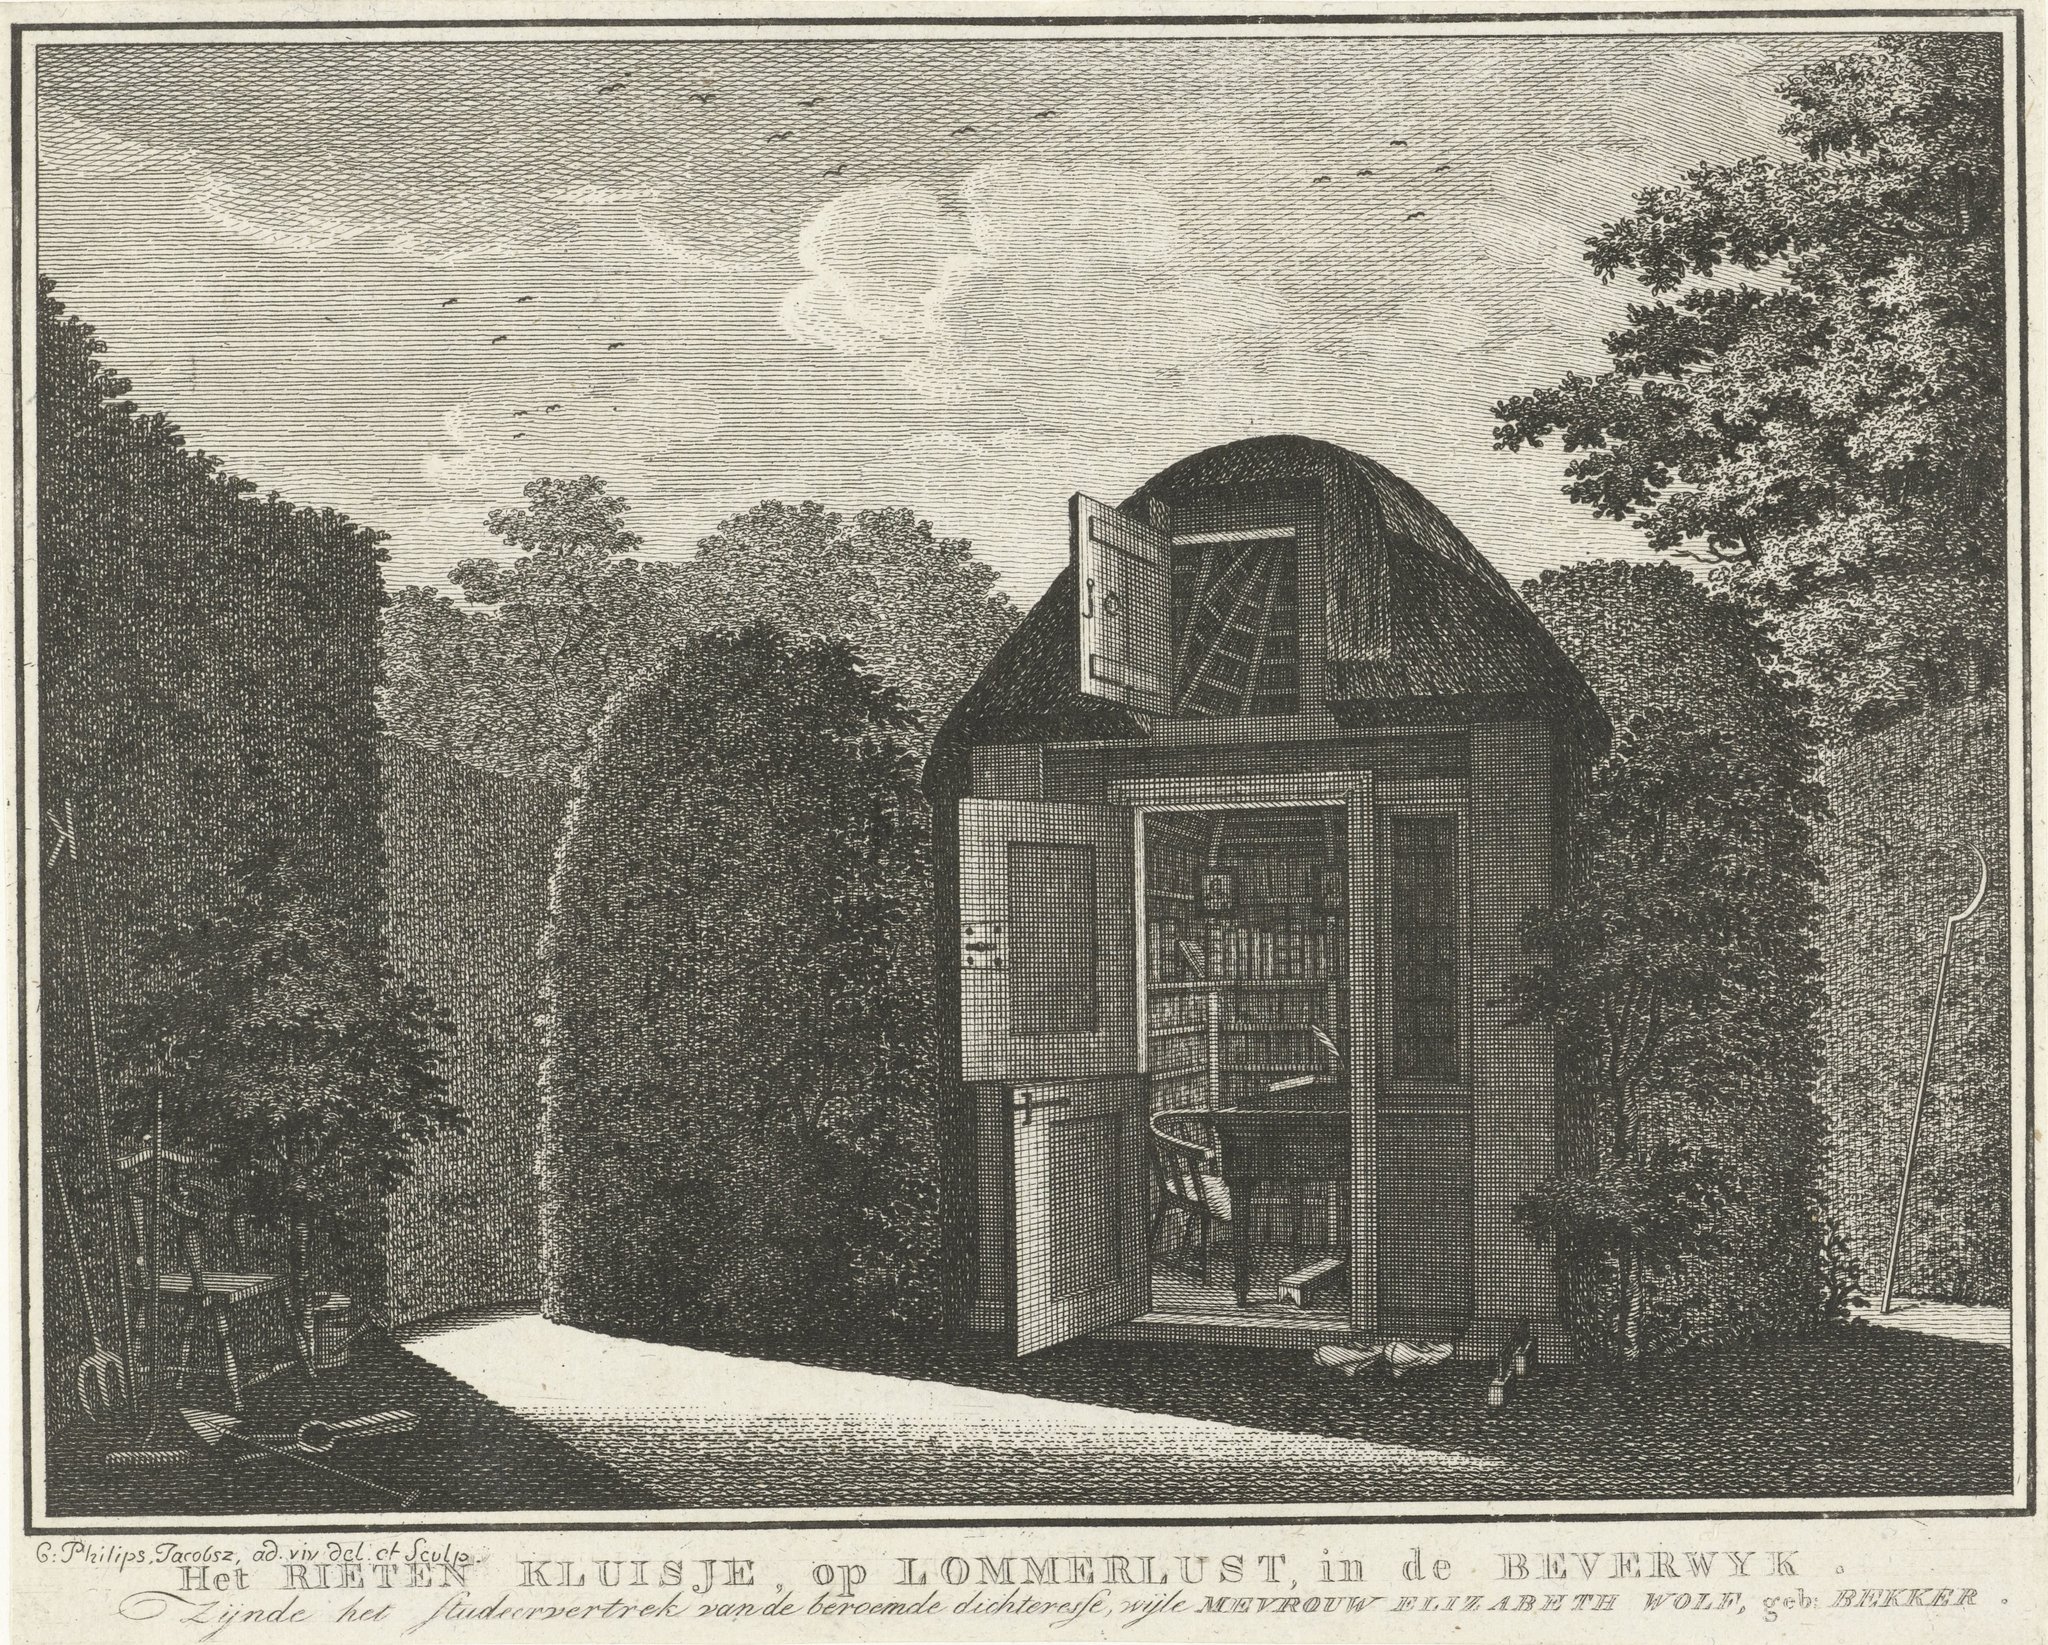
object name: print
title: Het Rieten Kluisje op Lommerlust, in de Beverwyk (...)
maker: caspar jacobsz. philips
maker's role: draughtsman, print maker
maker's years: 1732-1789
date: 1752-1789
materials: paper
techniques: etching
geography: amsterdam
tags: flushing, elisabeth bekker, the hague, agatha deken, garden, study; 'studiolo'; library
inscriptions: collector's mark: Lugt 2228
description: Gezicht op het tuinhuis van het buitenverblijf Lommerlust te Beverwijk, tussen 1782-1788 woonplaats van Betje Wolff en Aagje Deken.